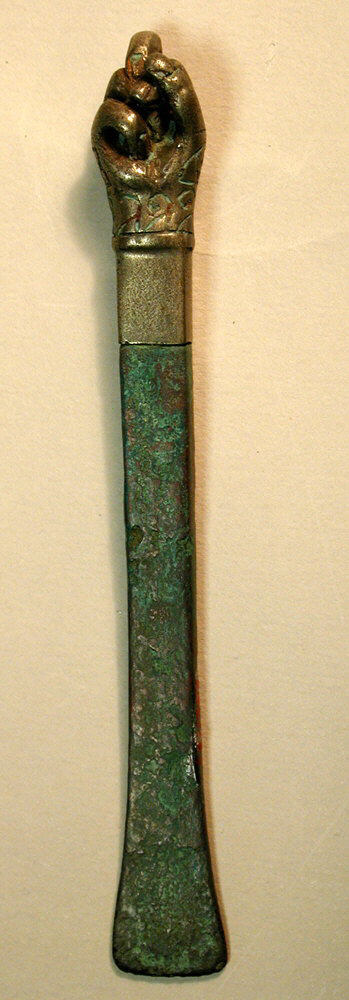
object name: spatula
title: Spatula with fist finial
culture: moche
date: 101-600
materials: copper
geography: peru